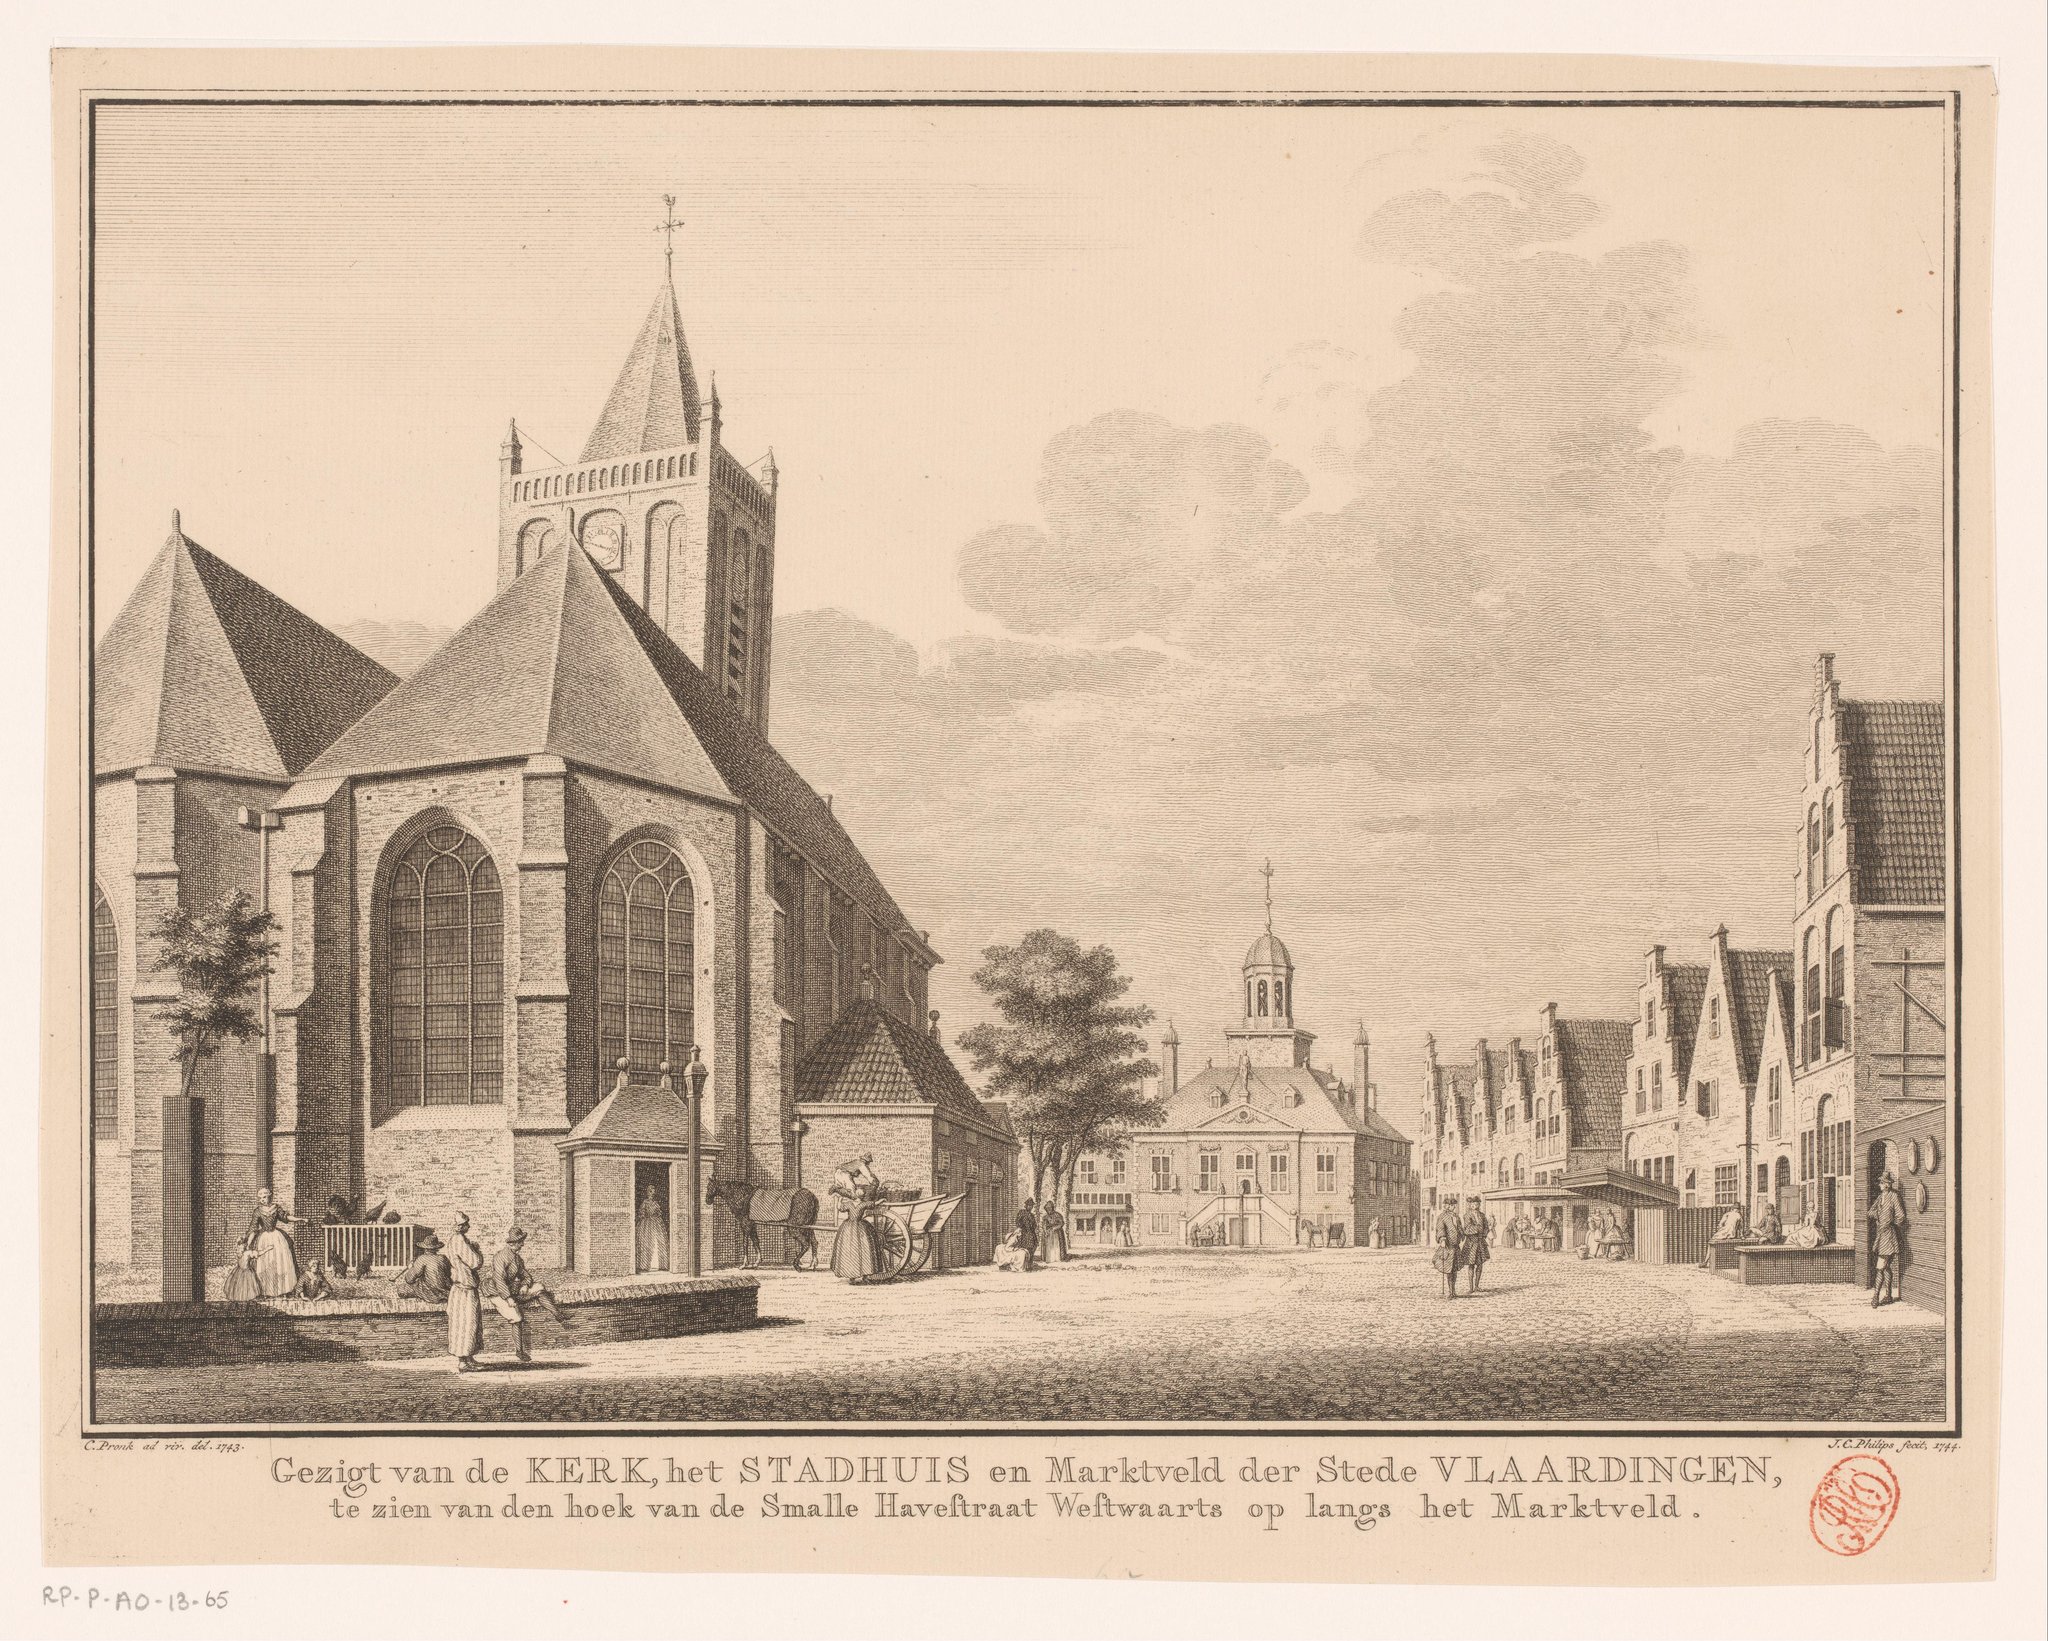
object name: print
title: Gezicht op de Grote Kerk en het Oude Stadhuis aan de Markt te Vlaardingen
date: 1744-1775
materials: paper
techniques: engraving, etching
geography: amsterdam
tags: church (exterior), townhall, market, village square, place (+ city(-scape) with figures, staffage)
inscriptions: collector's mark: Lugt 195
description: Prent ook gebruikt in: Handvesten, octroyen, privilegien en regten, aan de stede Vlaardingen (…) en met der stede grondteekening en andere kopere plaaten verçiert (…). Den Haag: Johannes Gaillard, 1772. En in: Handvesten, octroyen, privilegien en regten, aan de stede Vlaardingen (…) en met der stede grondteekening en andere kopere plaaten verçiert (…). Utrecht: Johannes van Schoonhoven, 1775.